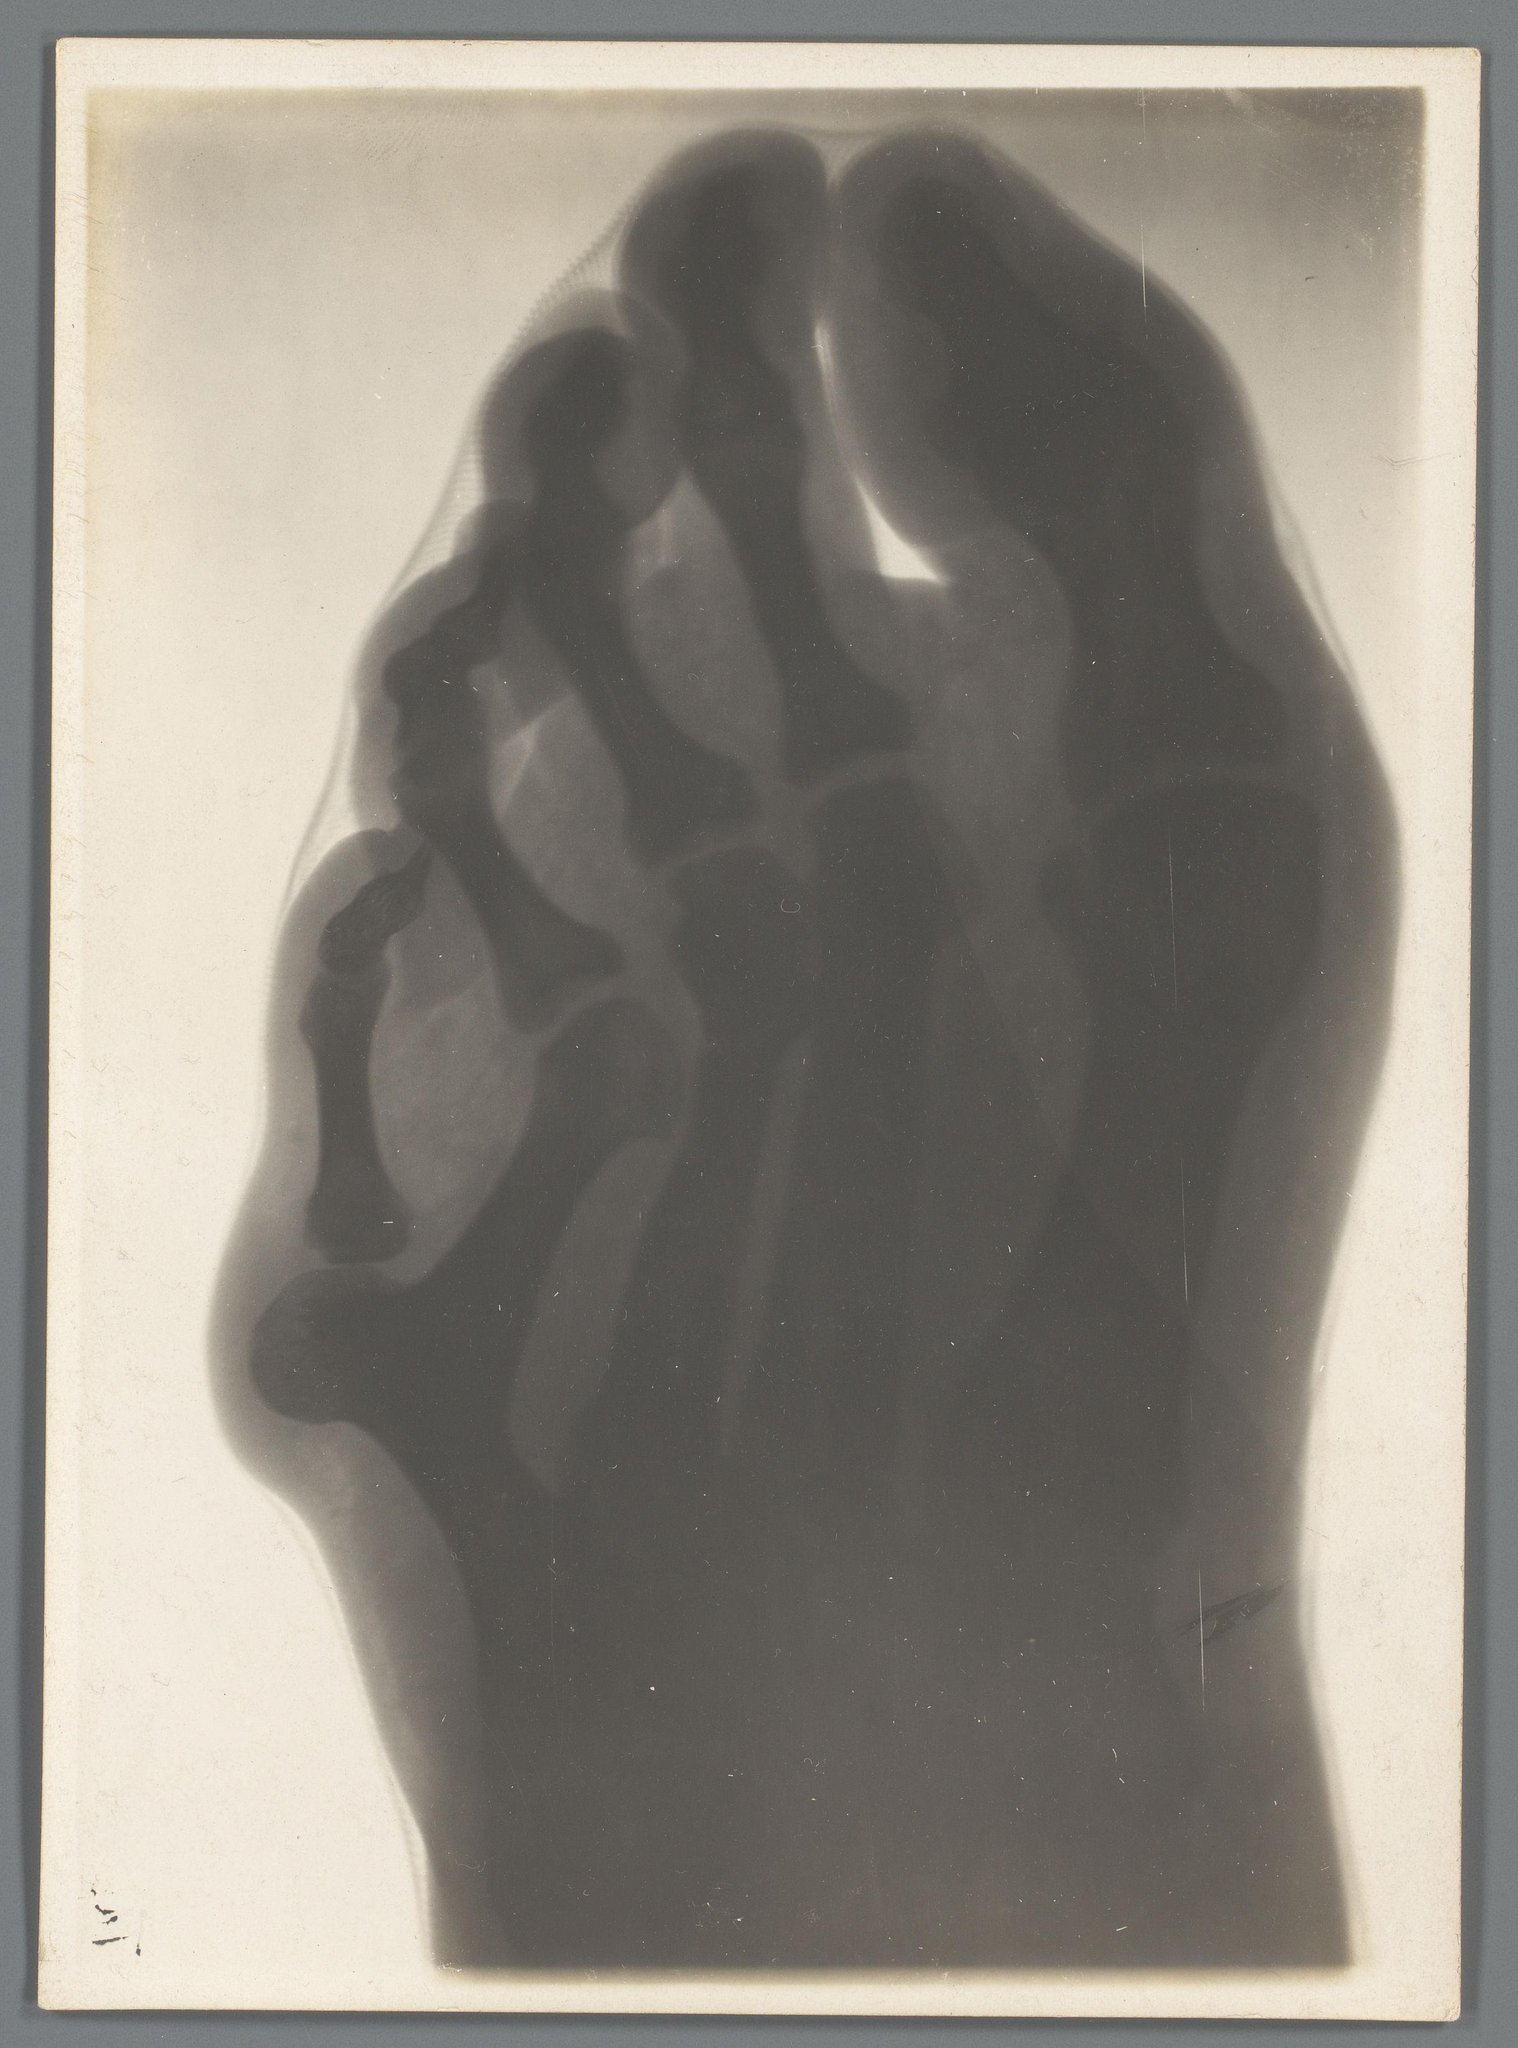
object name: x ray photograph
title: Voet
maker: jacob olie jr.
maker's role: fotograaf, scheikundige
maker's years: 1879-1955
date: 1901-1916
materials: paper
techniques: gelatin silver print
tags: foot